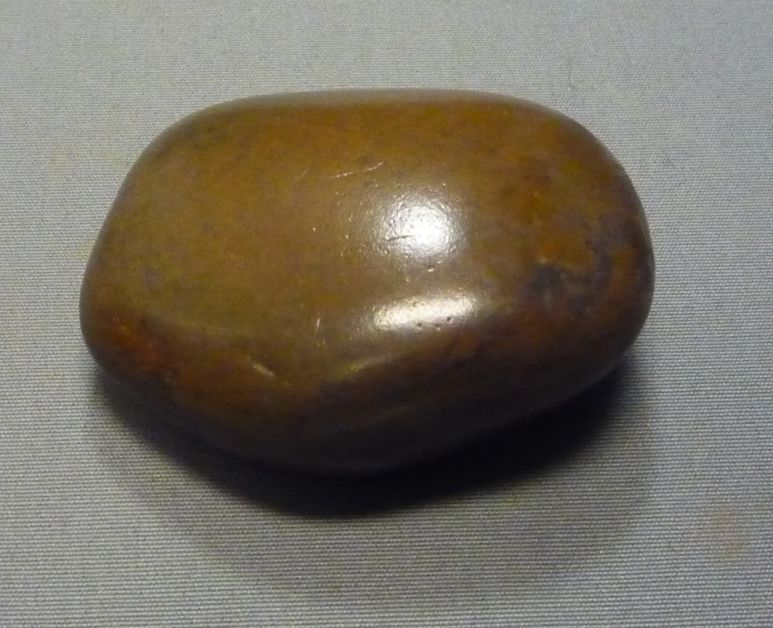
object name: polishing stone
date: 1479-1458 BCE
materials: stone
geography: egypt